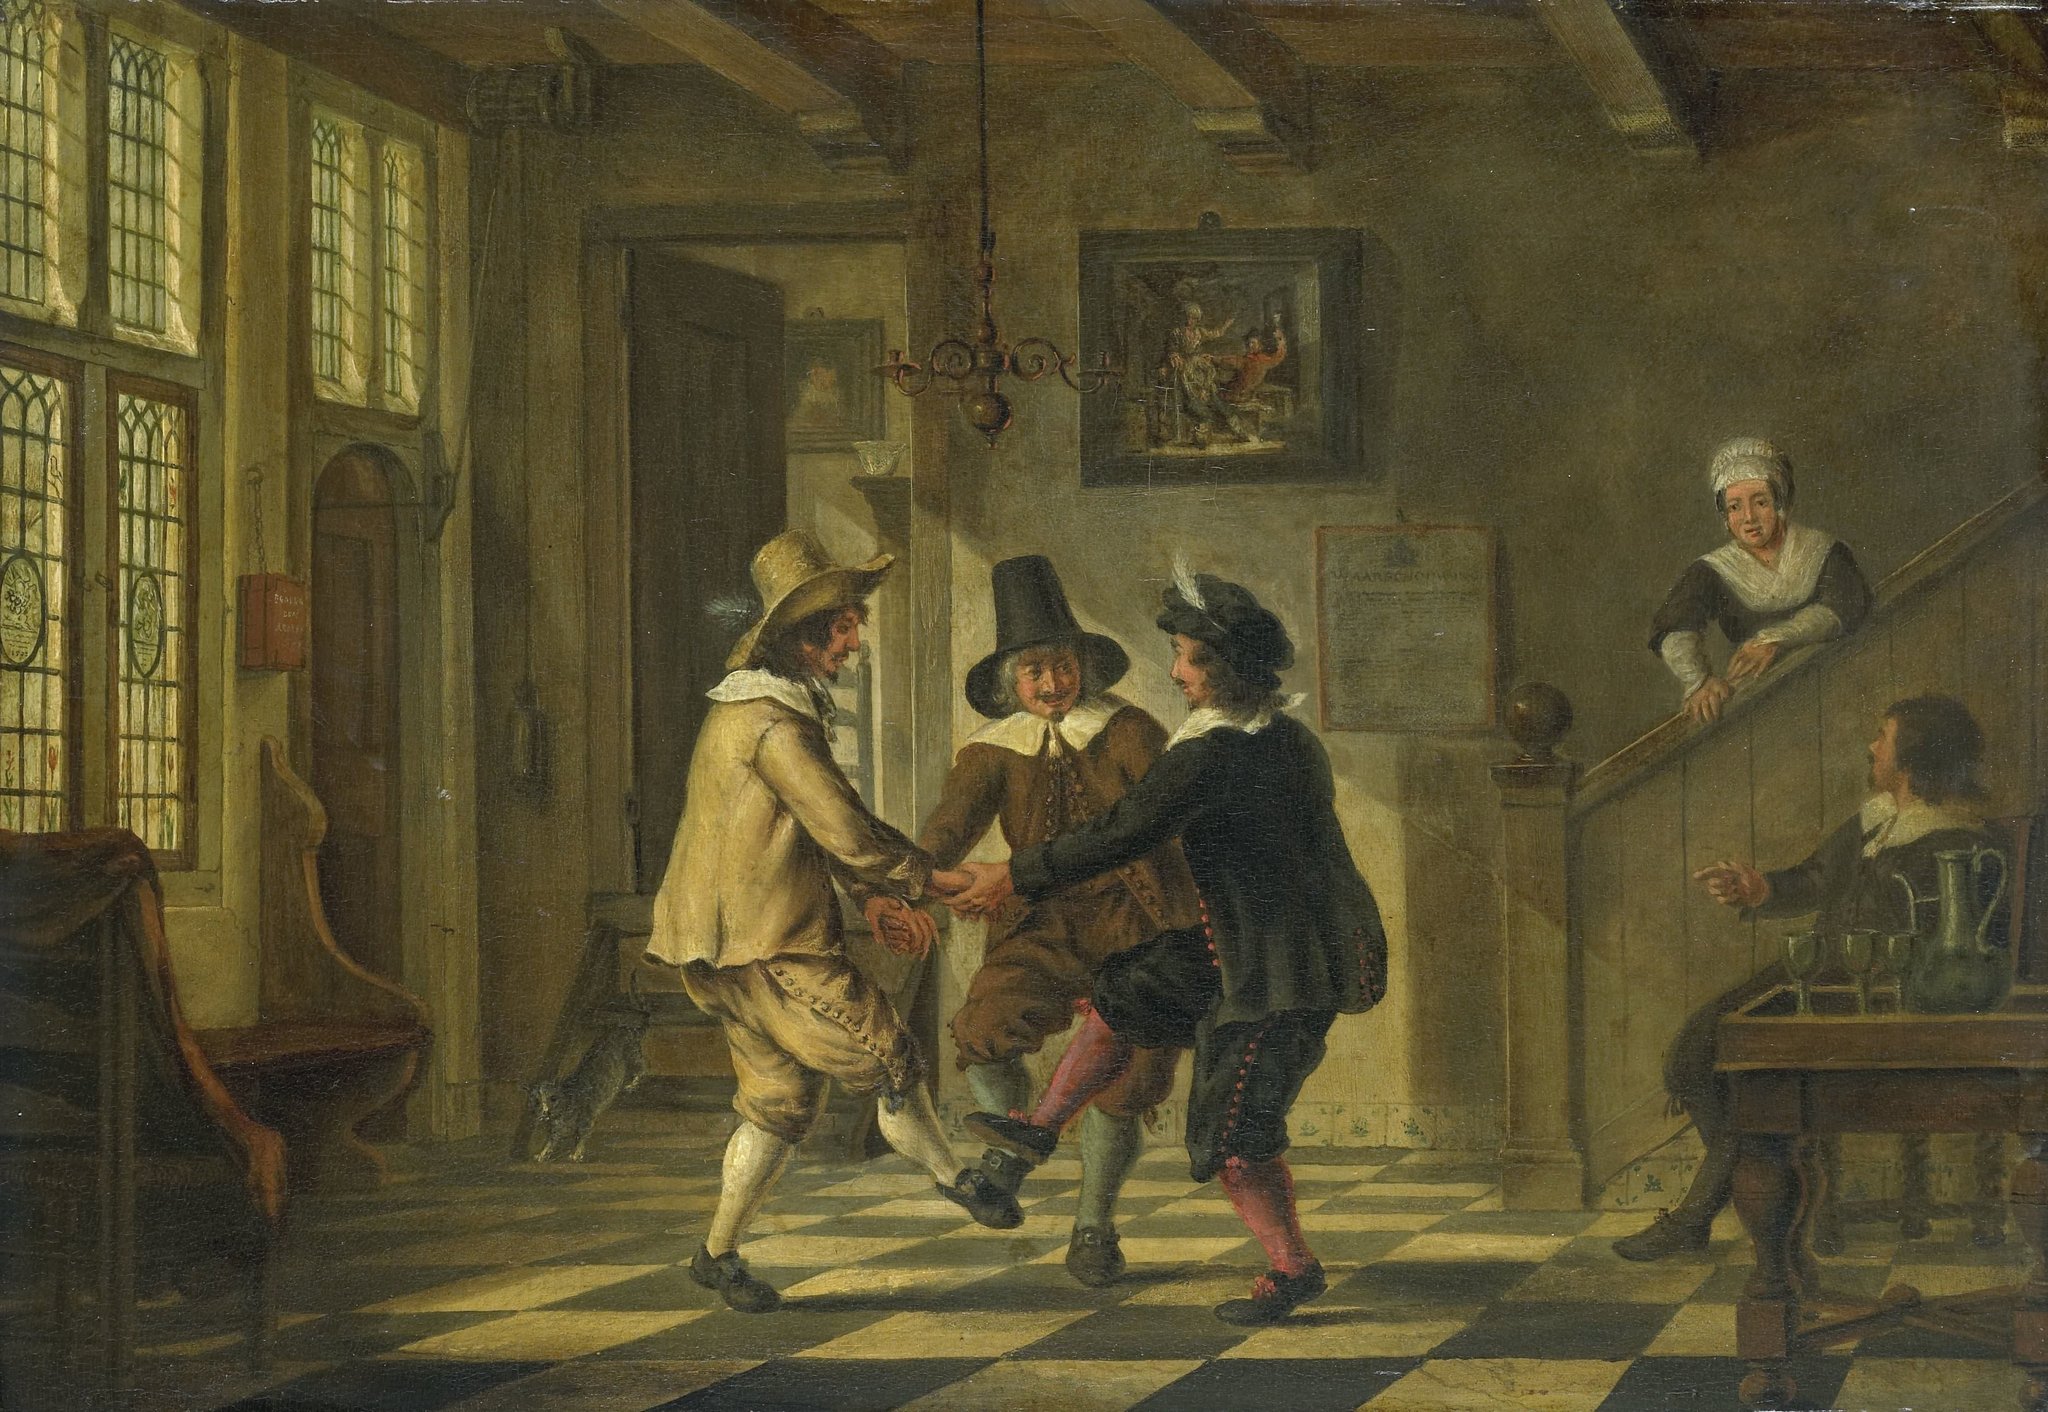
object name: painting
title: Drie mannen in zeventiende-eeuws kostuum dansend in een voorhuis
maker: Anonymous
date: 1700-1885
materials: oil, panel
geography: netherlands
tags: communal rooms, group of men (folk dancing)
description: Interieur met drie dansende mannen die elkaars handen vasthouden en een rondedans maken. Rechts aan een tafel zit een man en wijst naar het trio. Op de trap kijkt een vrouw toe. Aan de achterwand hangen twee schilderijen.